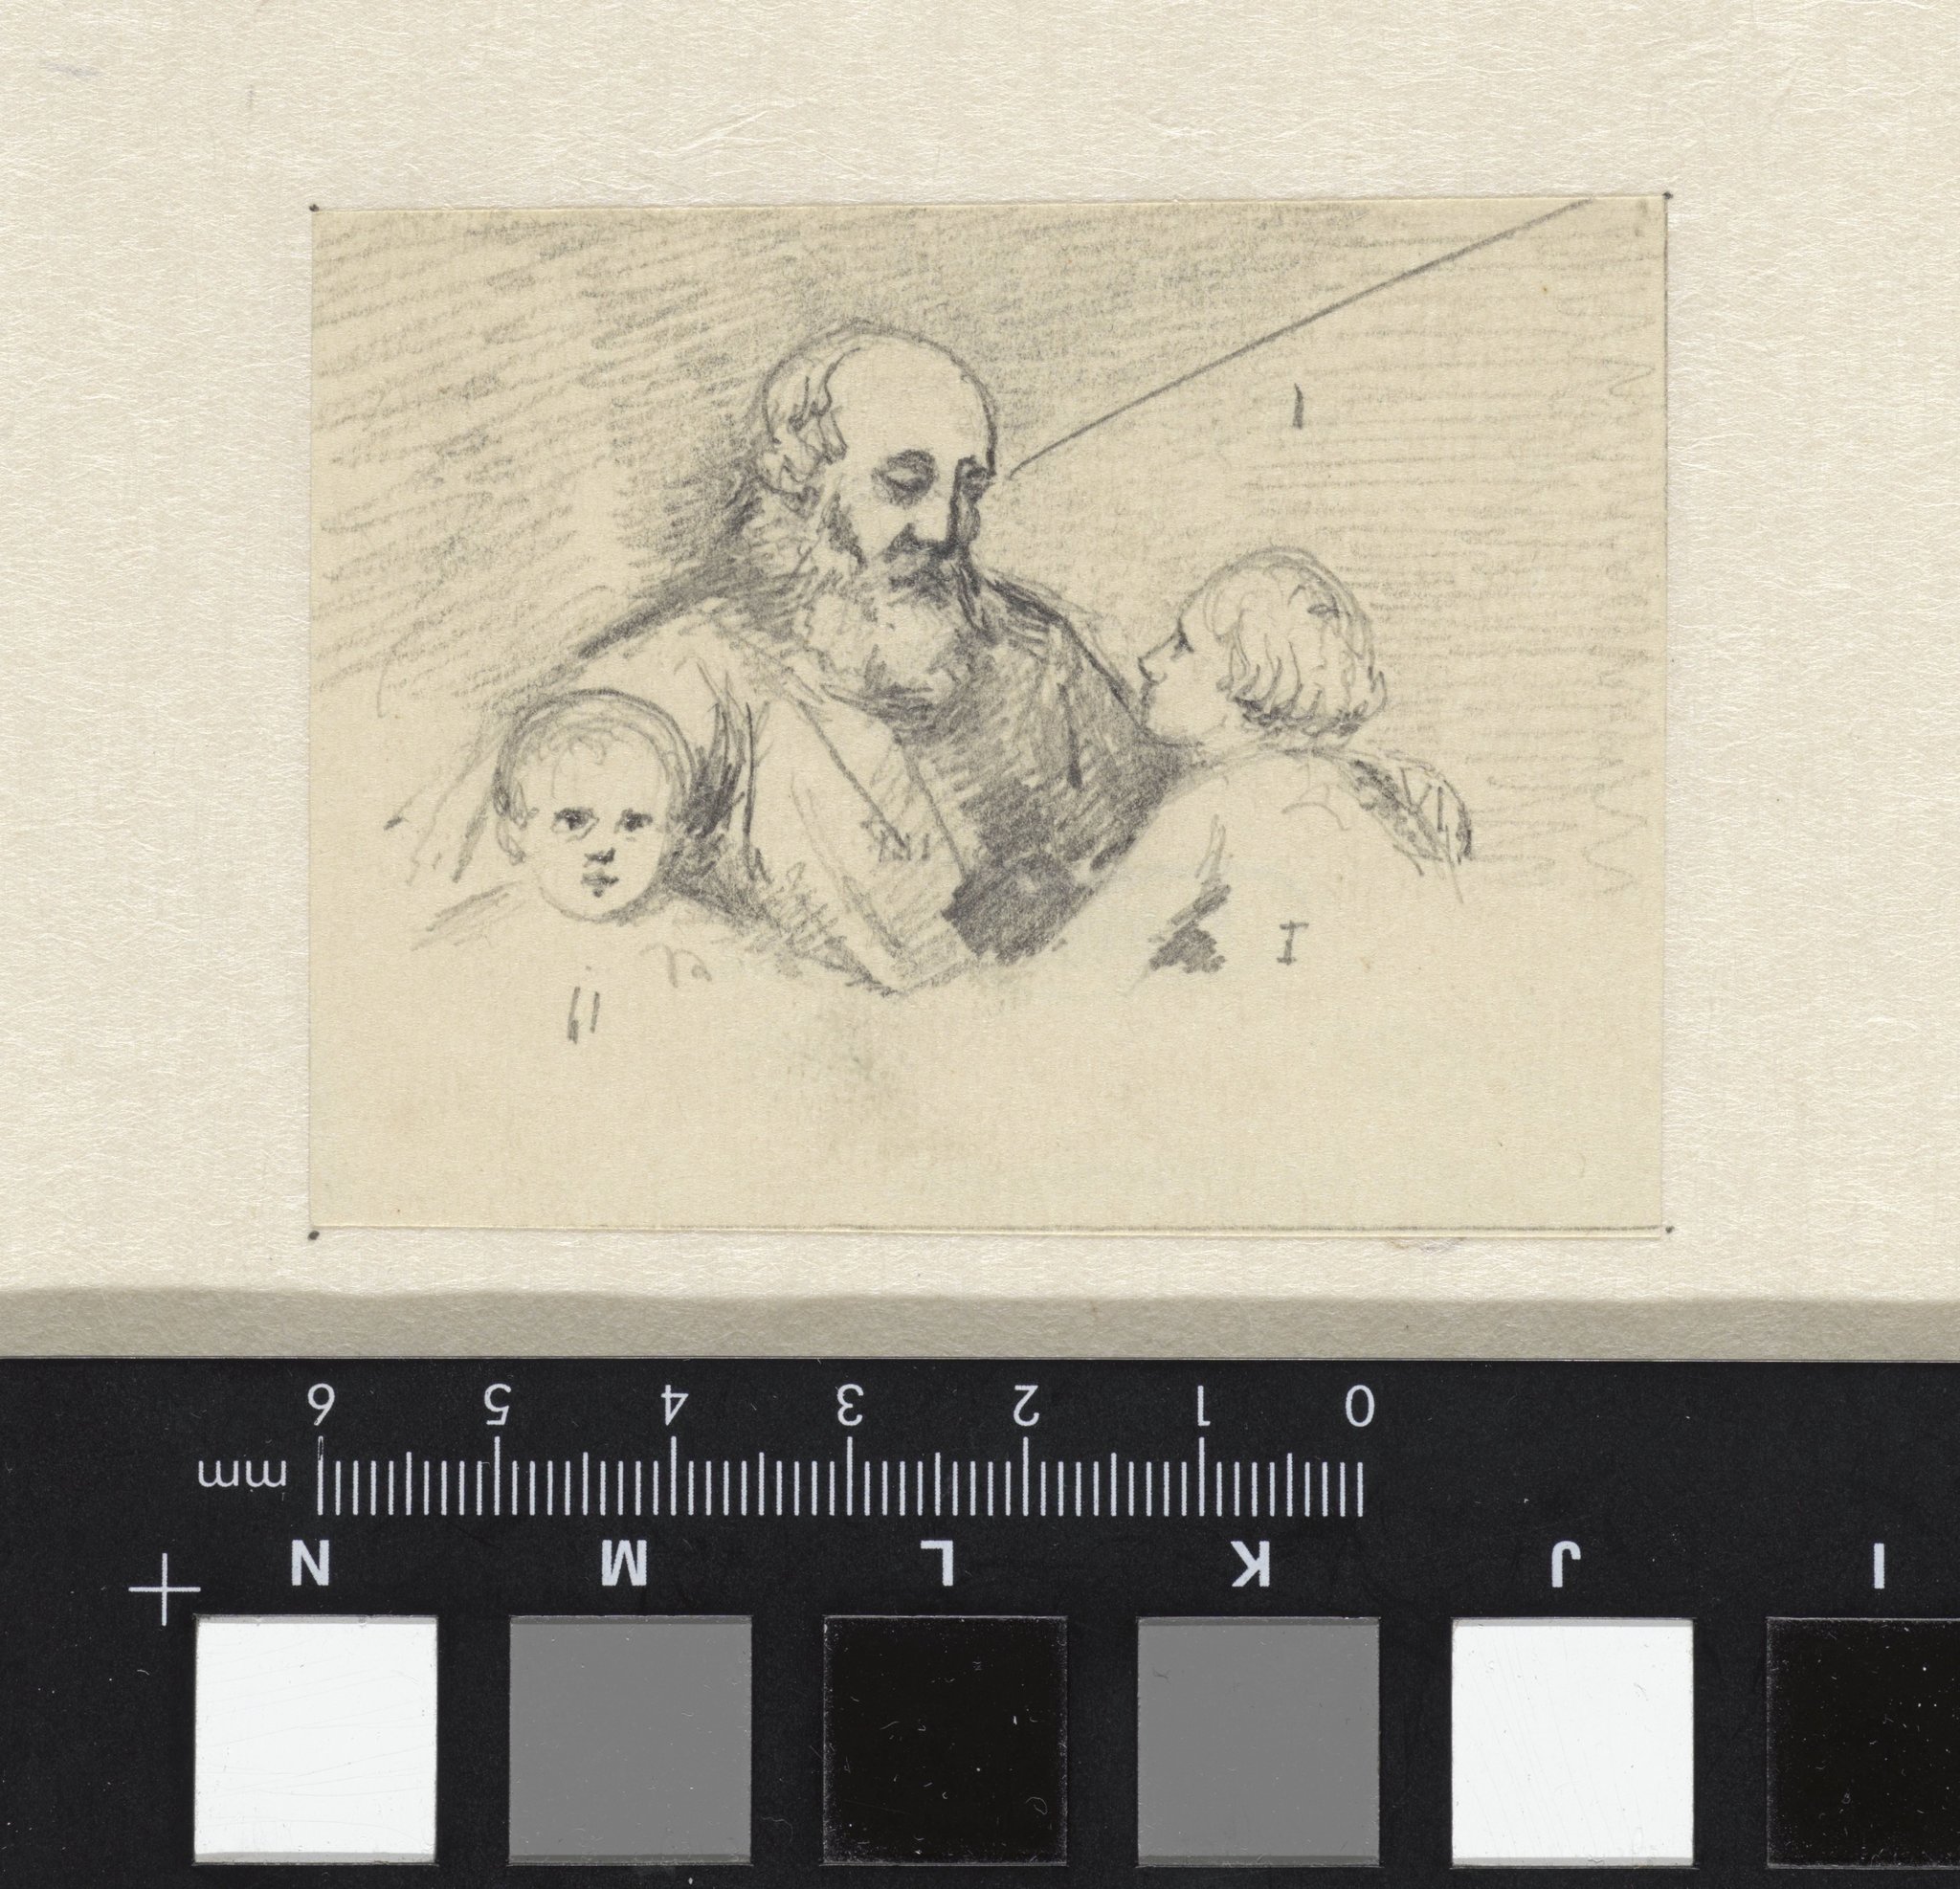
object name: design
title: De zittende grijsaard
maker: christiaan wilhelmus moorrees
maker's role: draughtsman, print maker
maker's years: 1801-1867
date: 1811-1867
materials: paper, pencil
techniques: pouncing